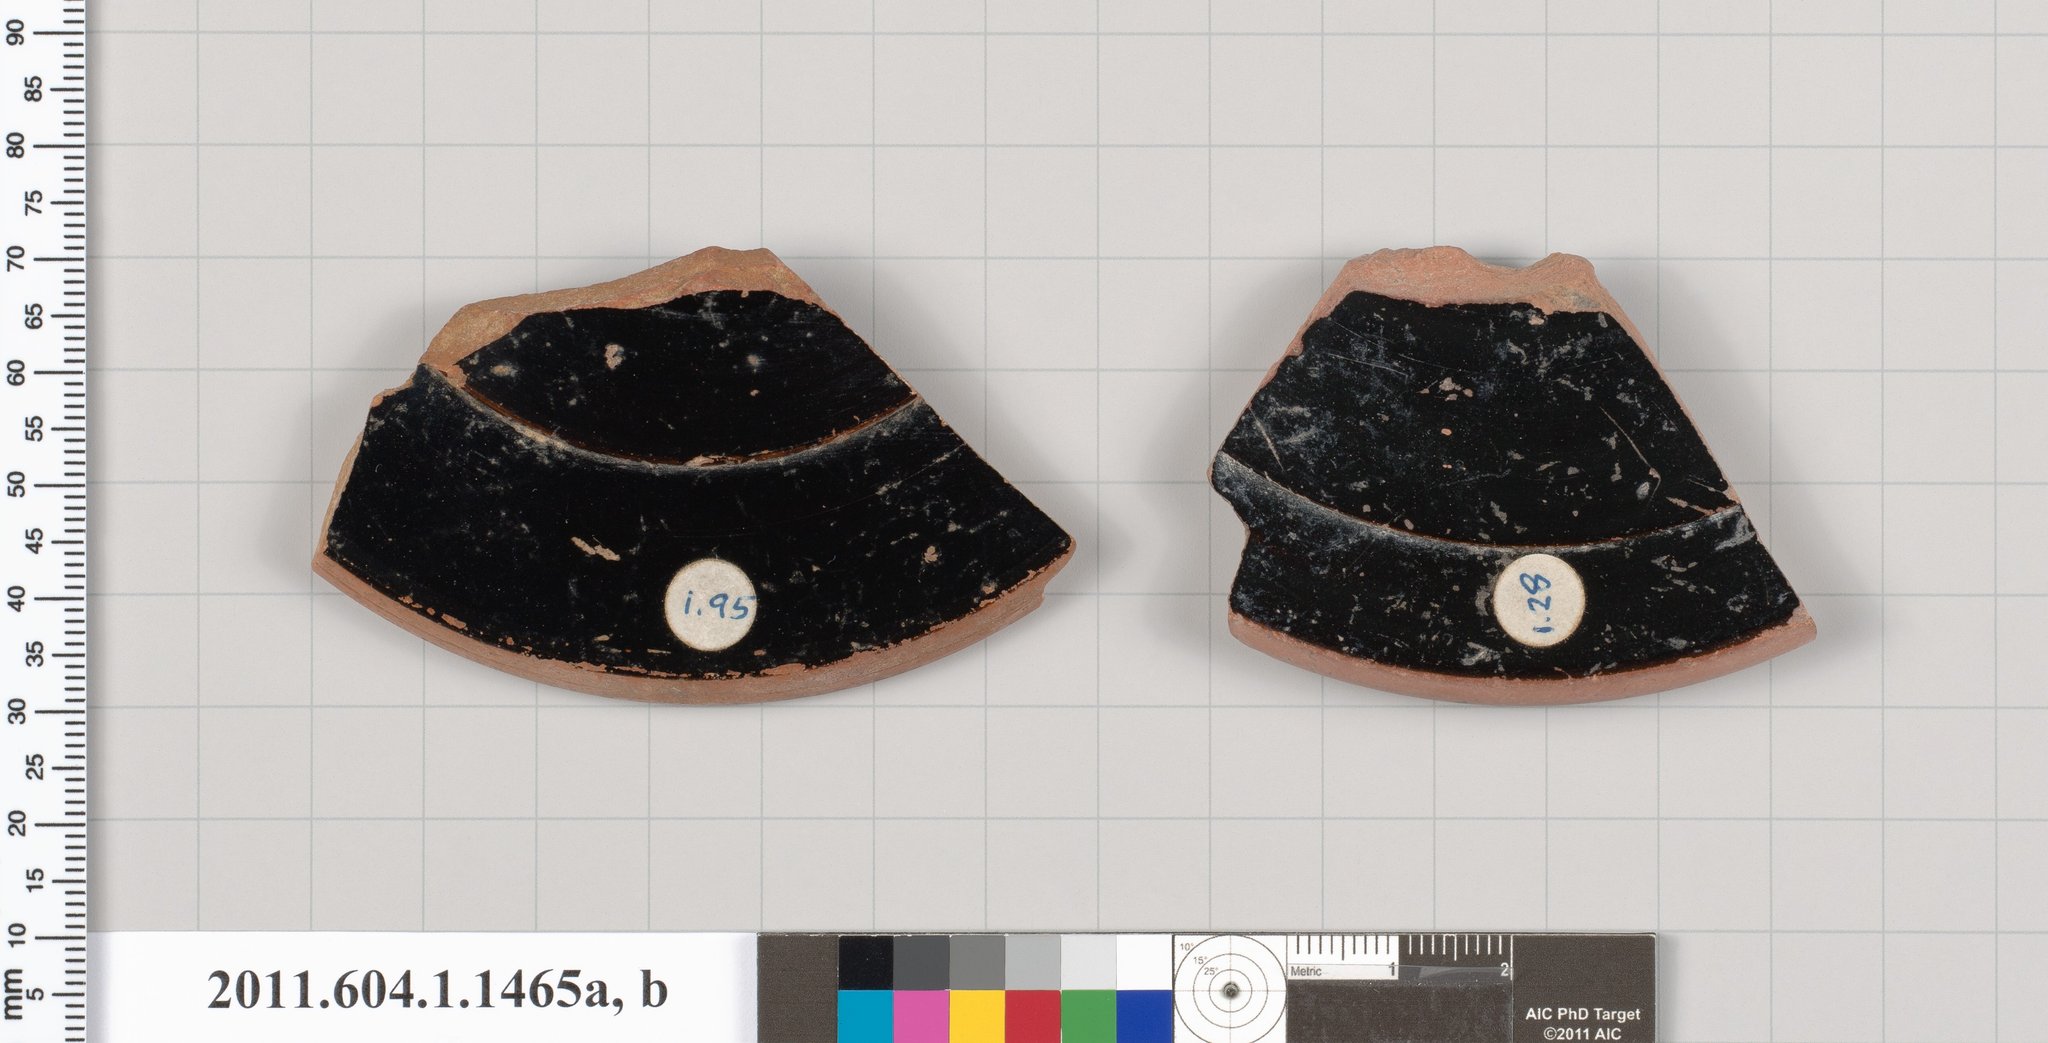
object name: kylix fragment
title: Terracotta fragments of kylikes (drinking cups)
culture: greek, attic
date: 500-401 BCE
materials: terracotta